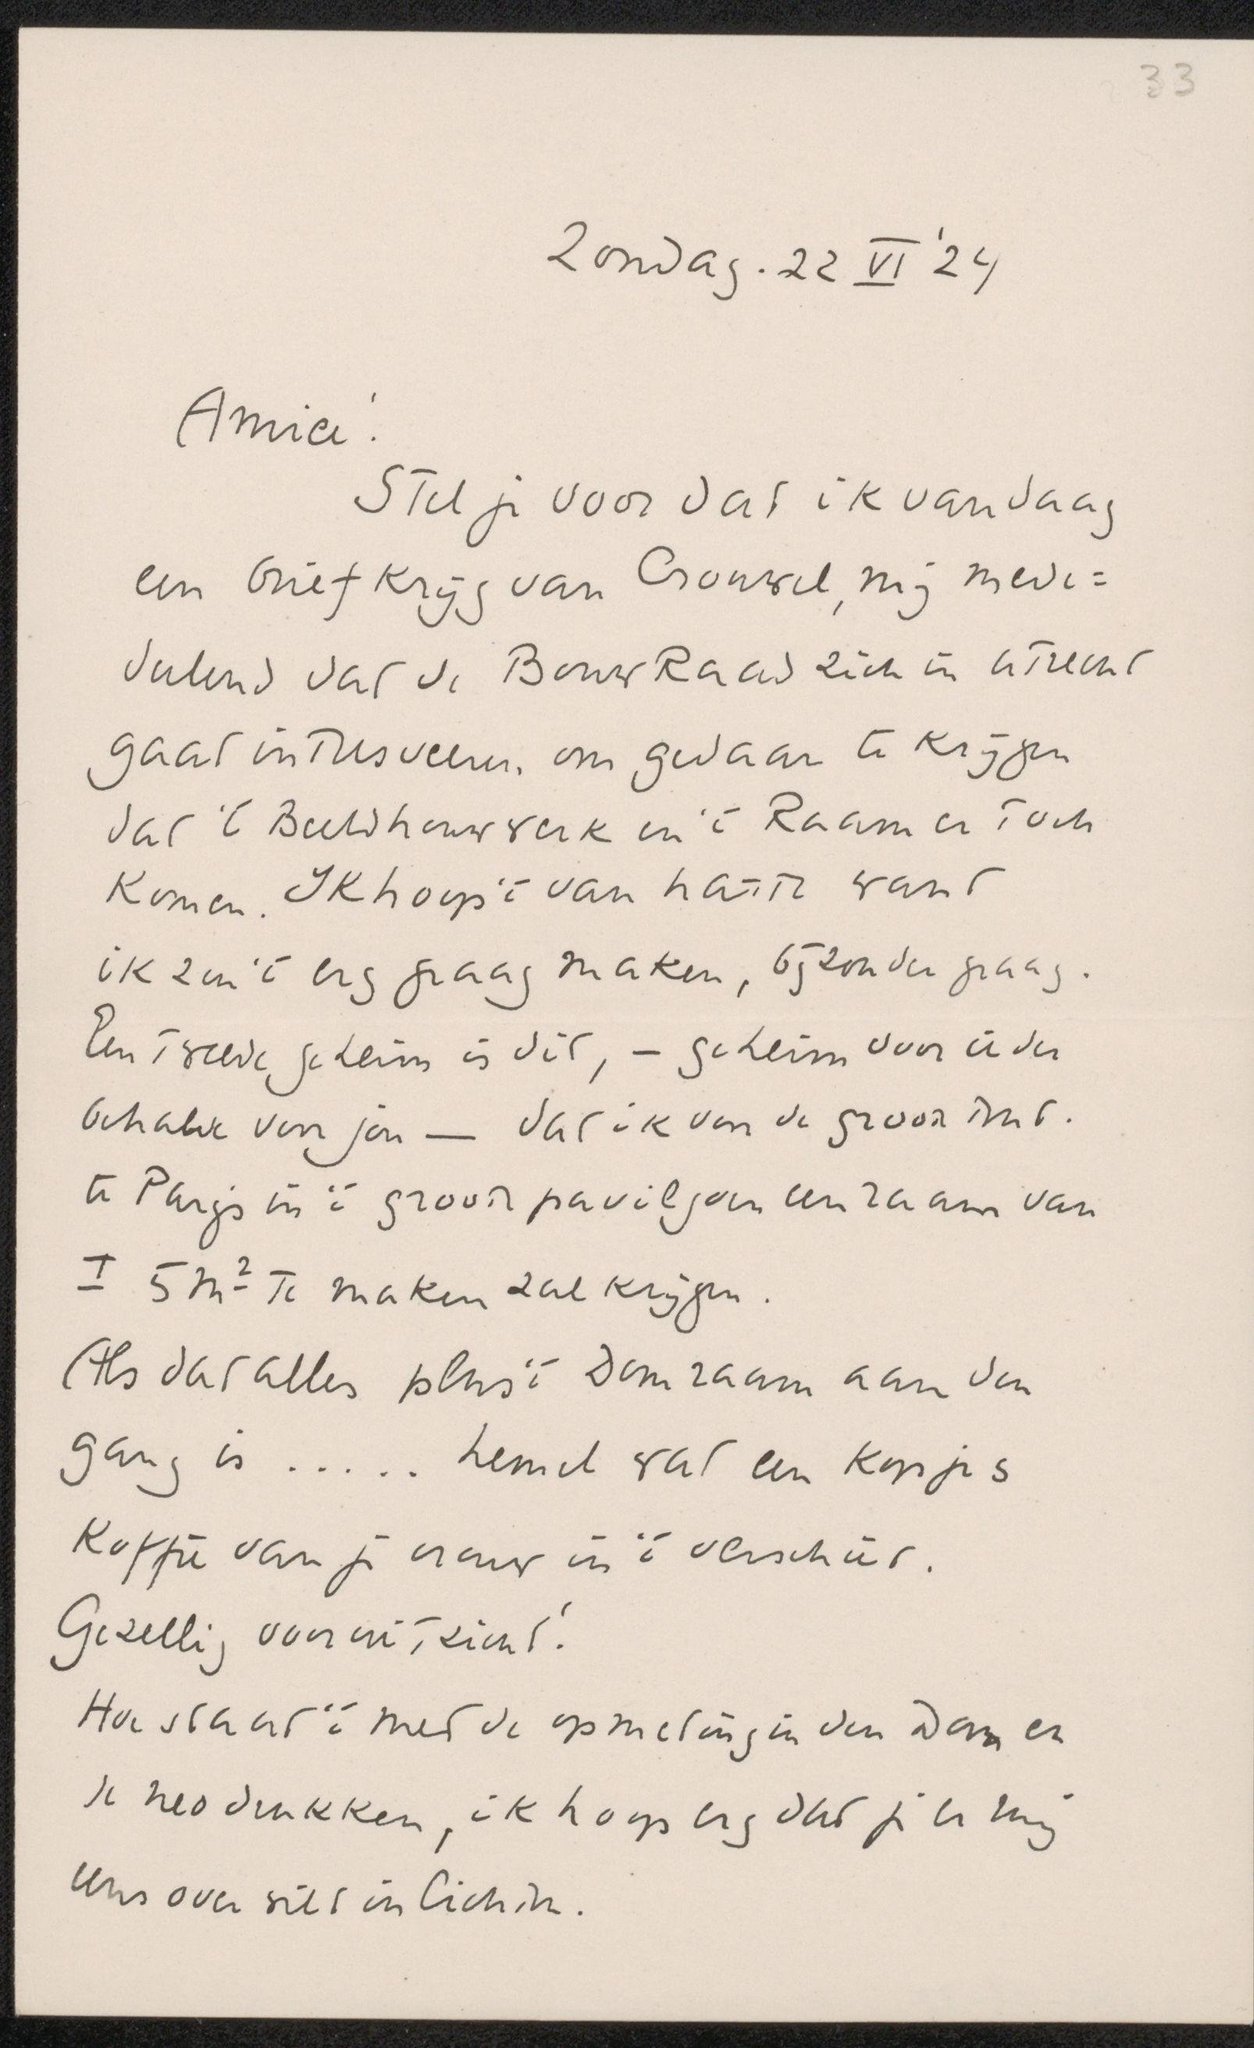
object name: letter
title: Brief aan Willem Bogtman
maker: richard nicolaüs roland holst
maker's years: 1868-1938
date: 1924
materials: ink, paper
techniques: pen, writing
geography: buissche heide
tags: haarlem, willem bogtman, utrecht, the hague, joseph crouwel, applied arts, arts and crafts; industrial design, the graphic arts, family life, sculpture, paris, amsterdam